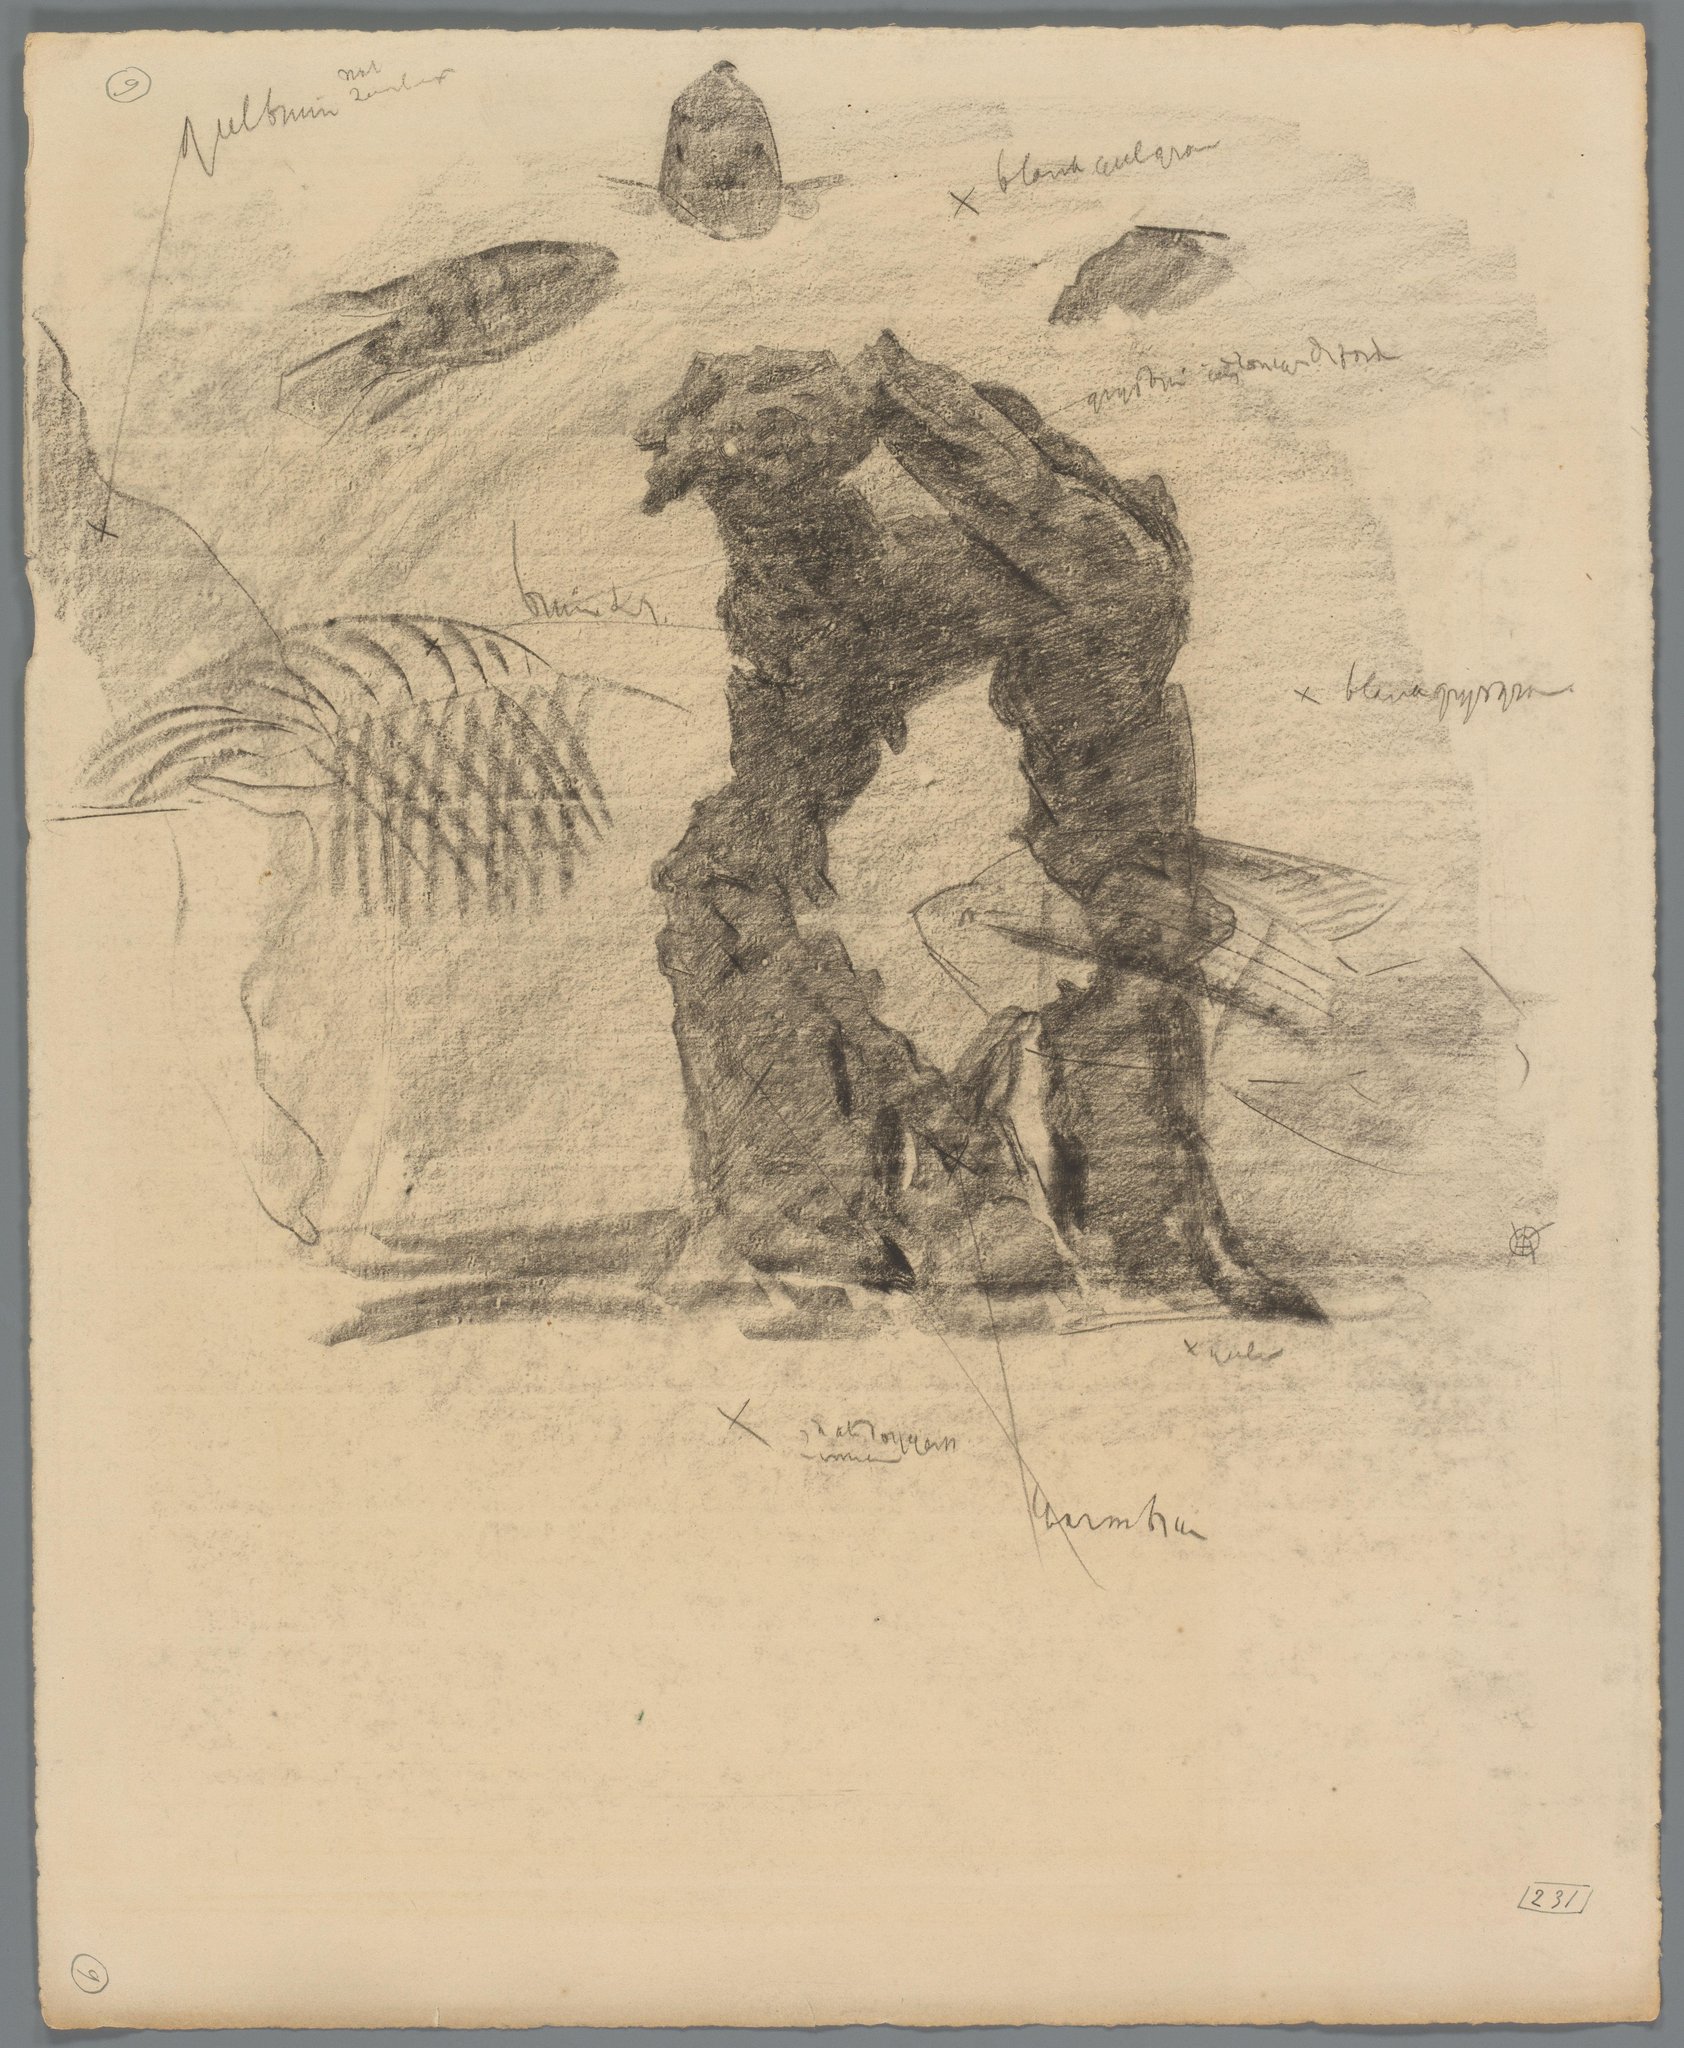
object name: drawing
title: Studie van een aquarium met vissen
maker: gerrit willem dijsselhof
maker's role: designer, draughtsman, print maker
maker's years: 1866-1924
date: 1876-1924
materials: chalk, paper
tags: aquarium, bony fishes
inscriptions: number: ‘231’, number: ‘9’